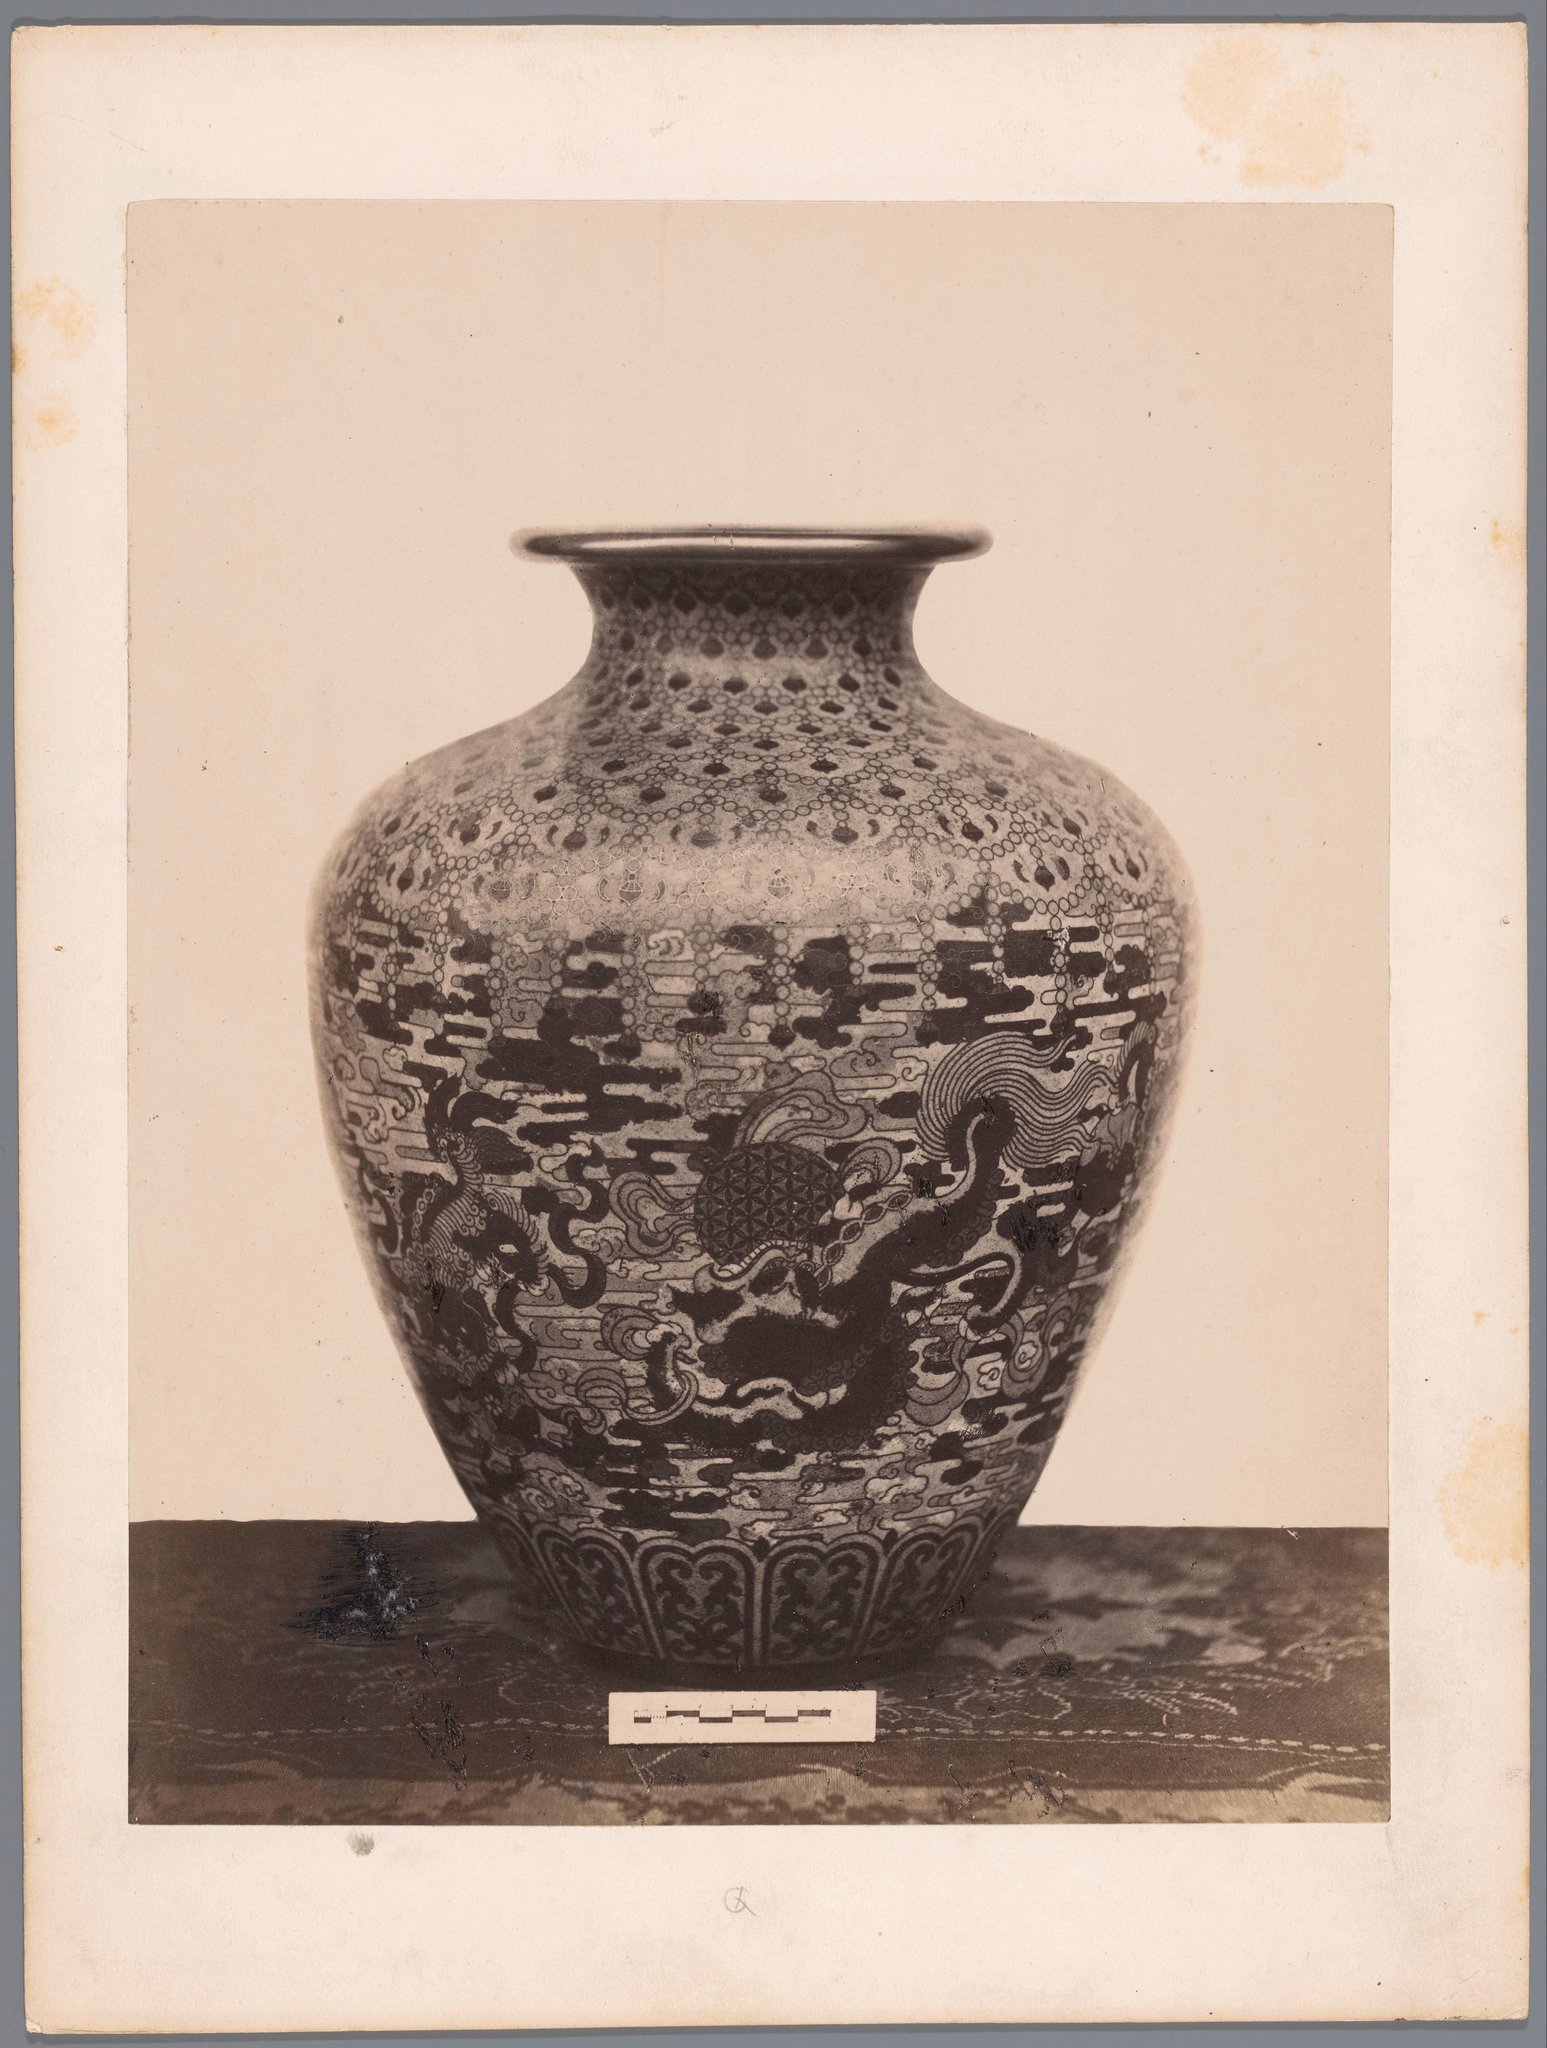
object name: photograph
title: Vaas gedecoreerd met aziatische motieven en draken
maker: Anonymous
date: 1875-1900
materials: cardboard, photographic support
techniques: albumen print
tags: applied arts, arts and crafts; industrial design, dragon, container of ceramics: jar, jug, pot, vase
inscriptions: collector's mark: Lugt 3937